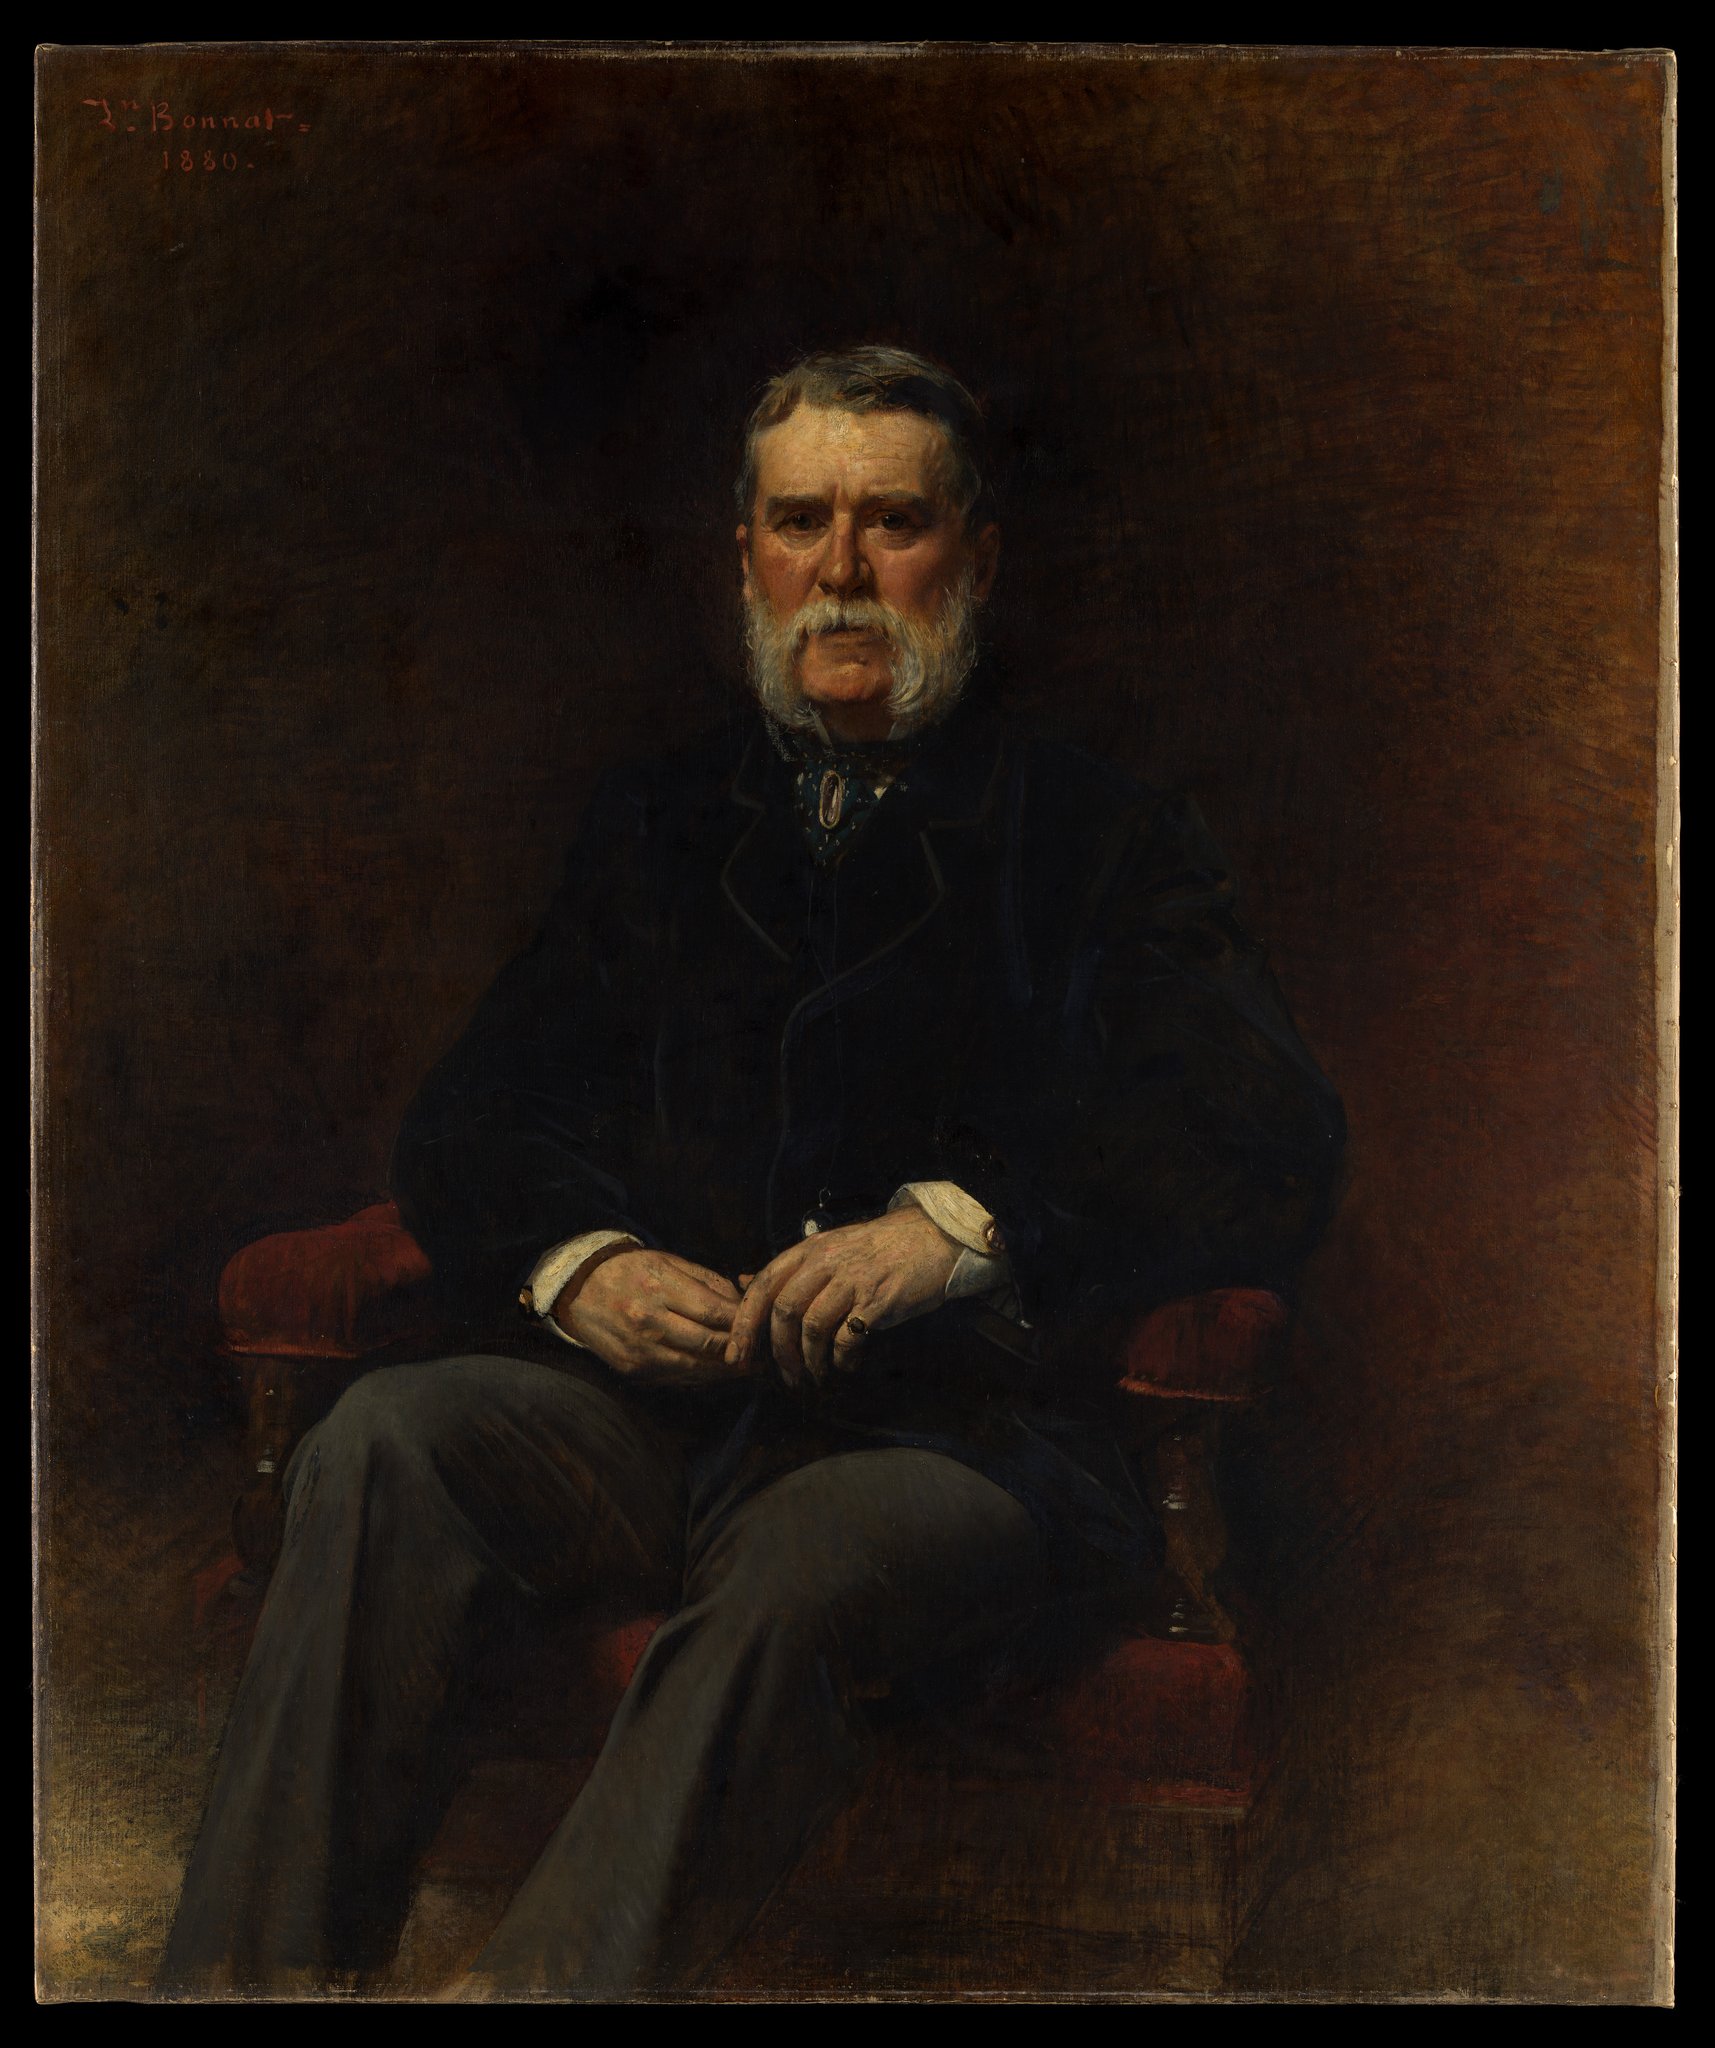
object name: painting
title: John Taylor Johnston (1820–1893)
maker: léon bonnat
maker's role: artist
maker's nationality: french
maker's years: 1833-1922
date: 1880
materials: canvas, oil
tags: men,portraits